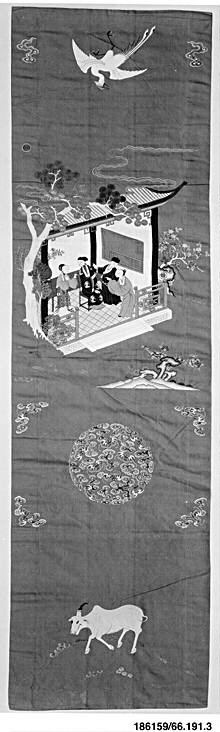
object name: chair strip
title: One of a Set of Twelve Chair Strips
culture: chinese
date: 1701-1833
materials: metal, textile, silk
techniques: embroidery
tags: human figures,animals,cranes,houses